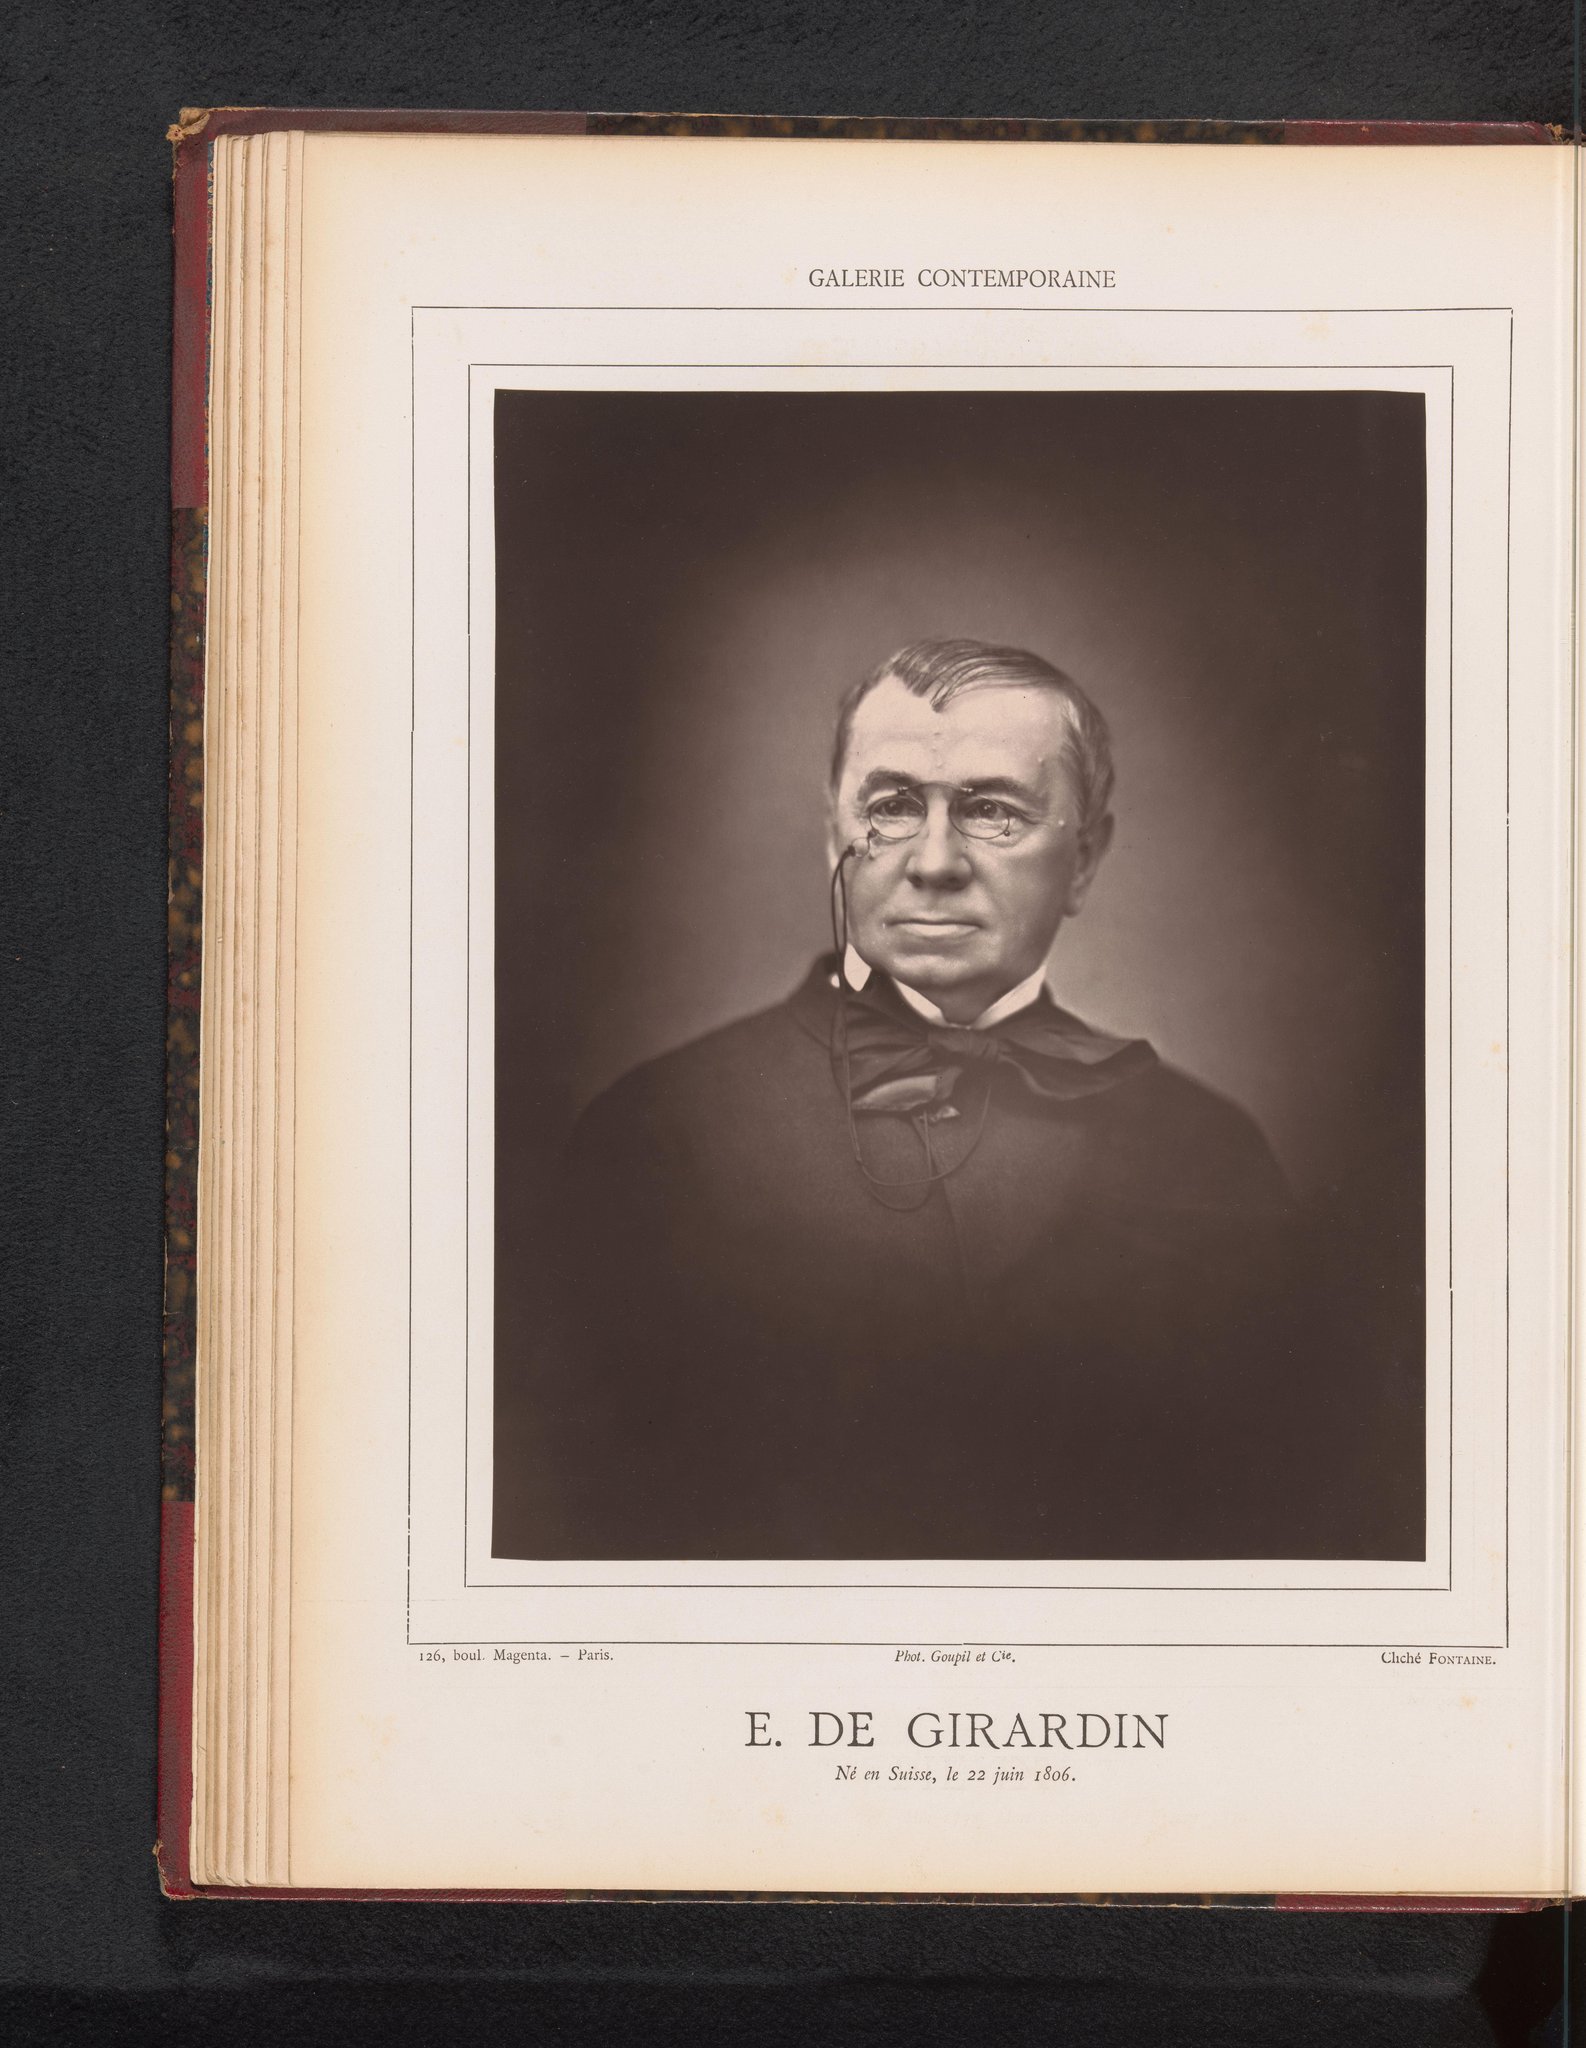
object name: page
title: Portret van Émile de Girardin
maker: fontaine (fotograaf)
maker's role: clichémaker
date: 1871-1876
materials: paper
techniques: woodburytype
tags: publisher, émile de girardin, adult man, historical persons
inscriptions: inscription: ‘126, boul. Magenta - Paris/ Né en Suisse, le 22 juin 1806.’